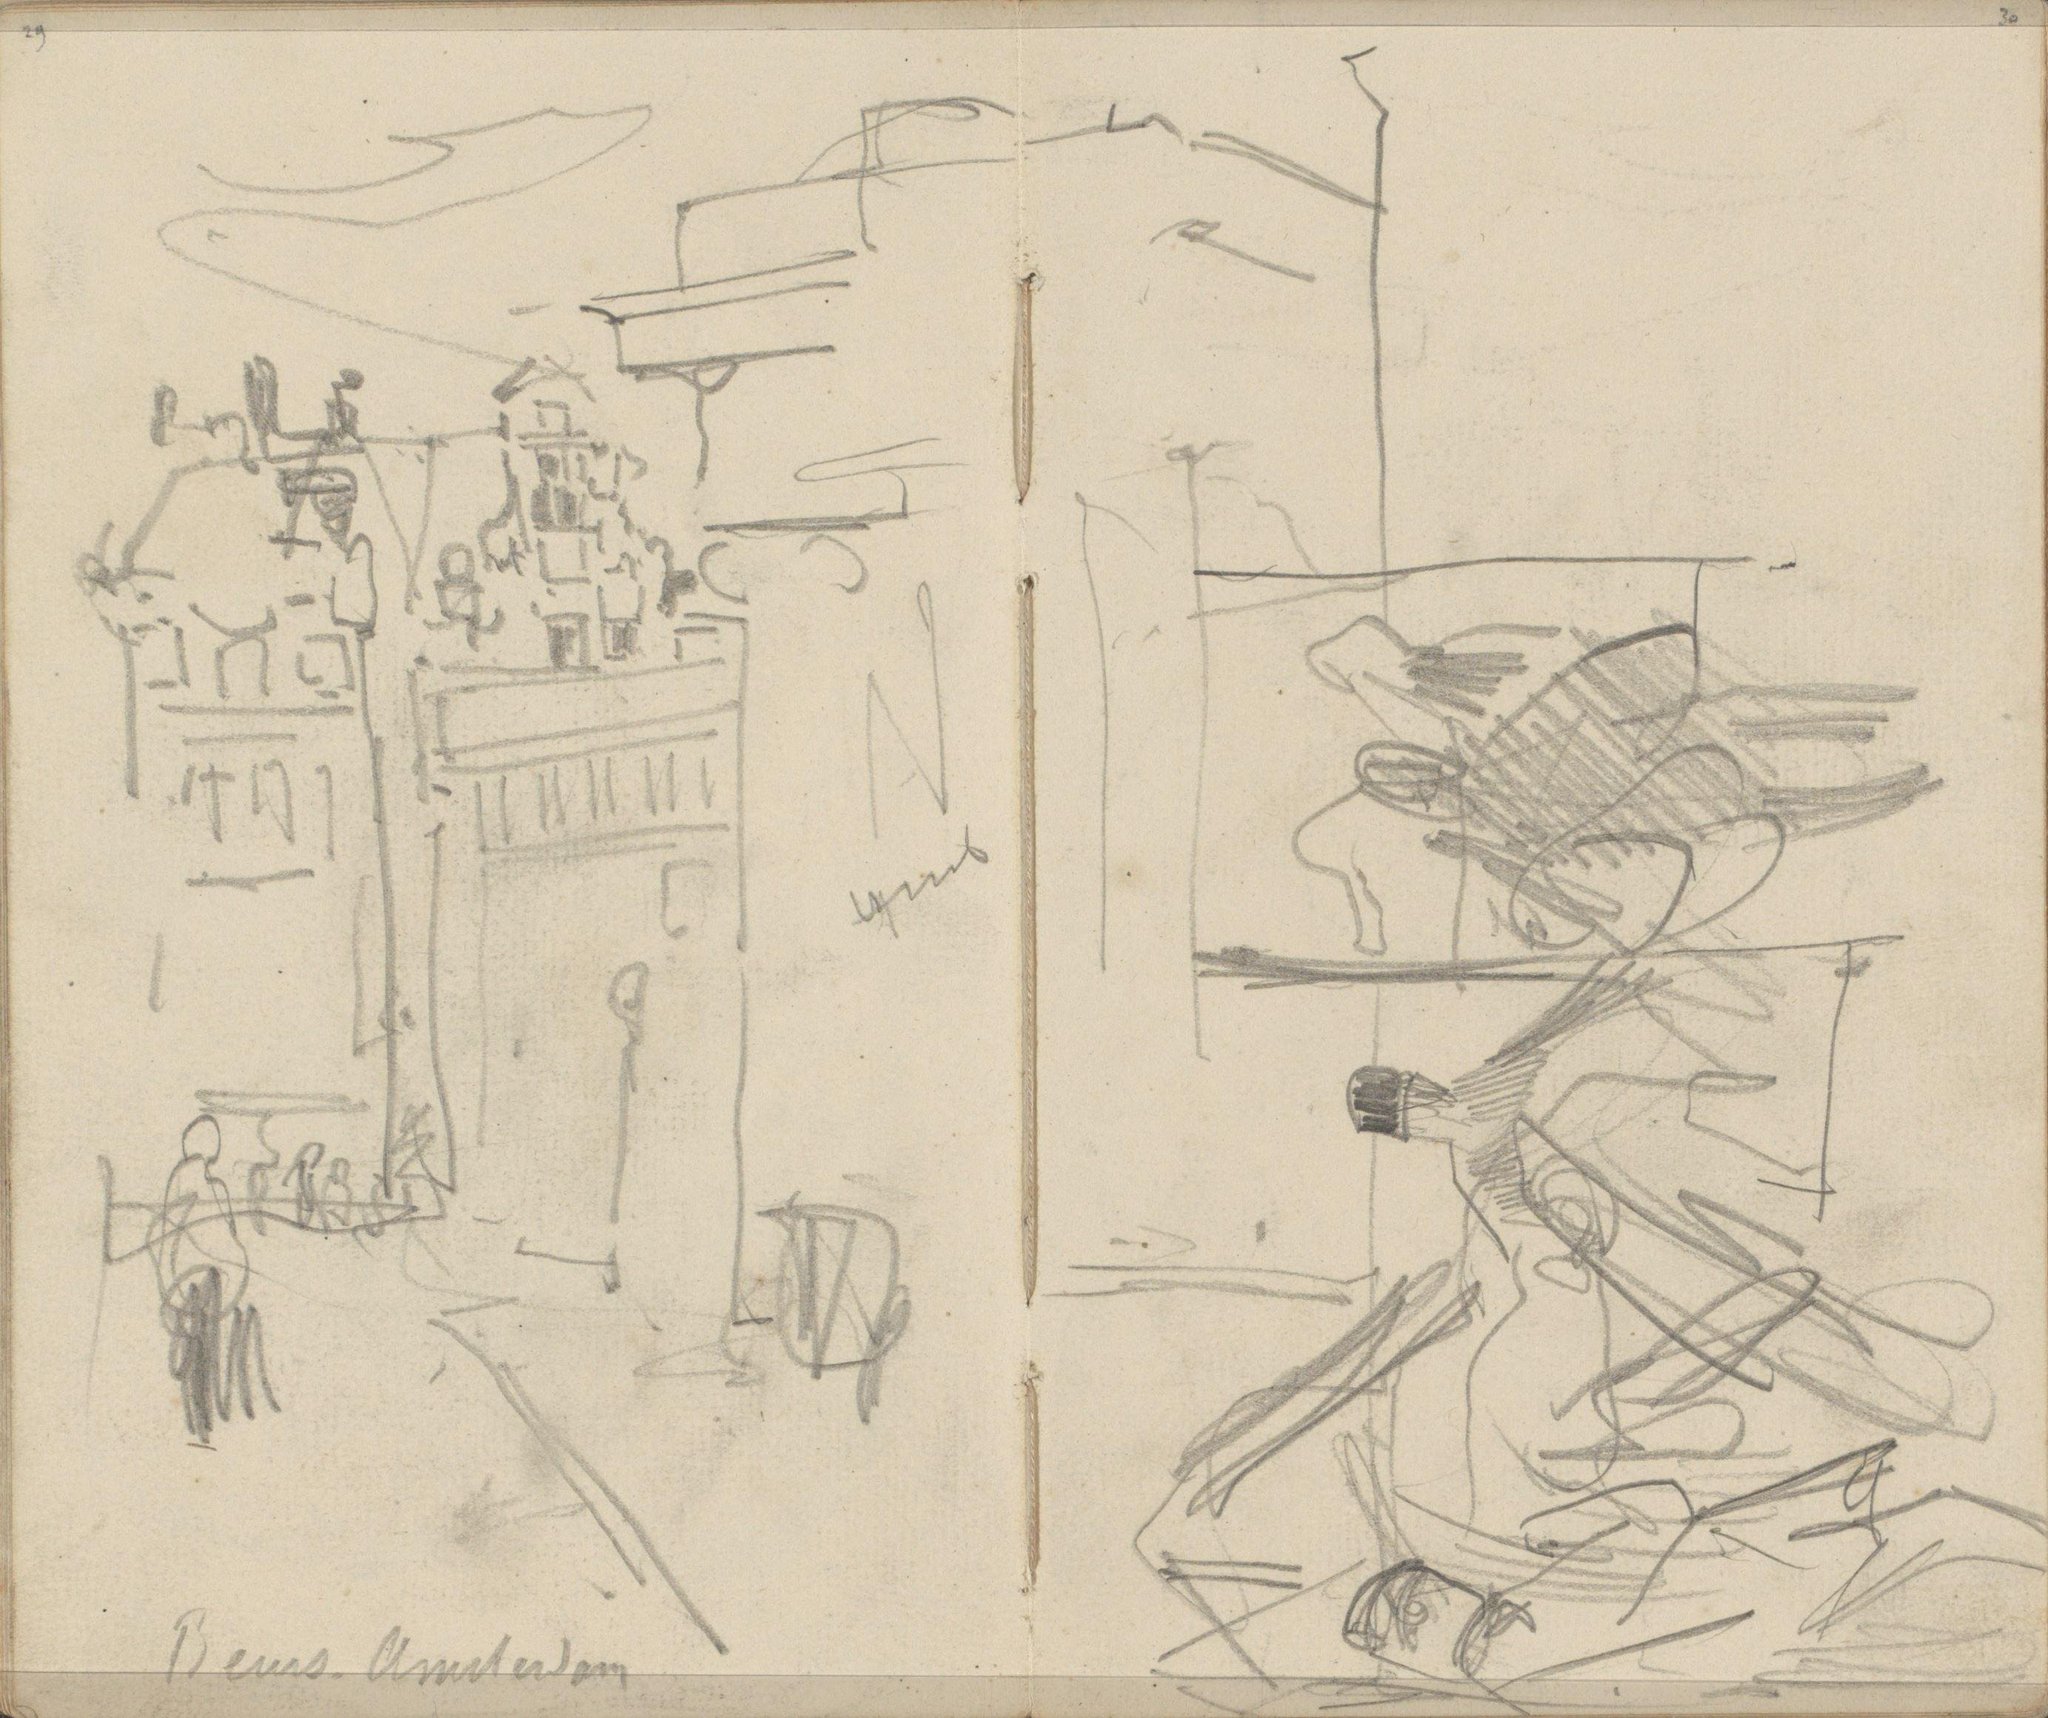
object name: sketchbook leaf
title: Beurs van Zocher op de Dam te Amsterdam, gezien naar de ingang van het Damrak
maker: george hendrik breitner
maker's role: draughtsman, painter, print maker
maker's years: 1857-1923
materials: paper, pencil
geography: amsterdam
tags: urban housing, adult woman, adult man, square, place, circus, etc. (+ city(-scape) with figures, staffage)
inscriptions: annotation: ‘Beurs. Amsterdam’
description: Verder figuurstudies. Pagina 29 en pagina 30 uit een schetsboek met 28 bladen.